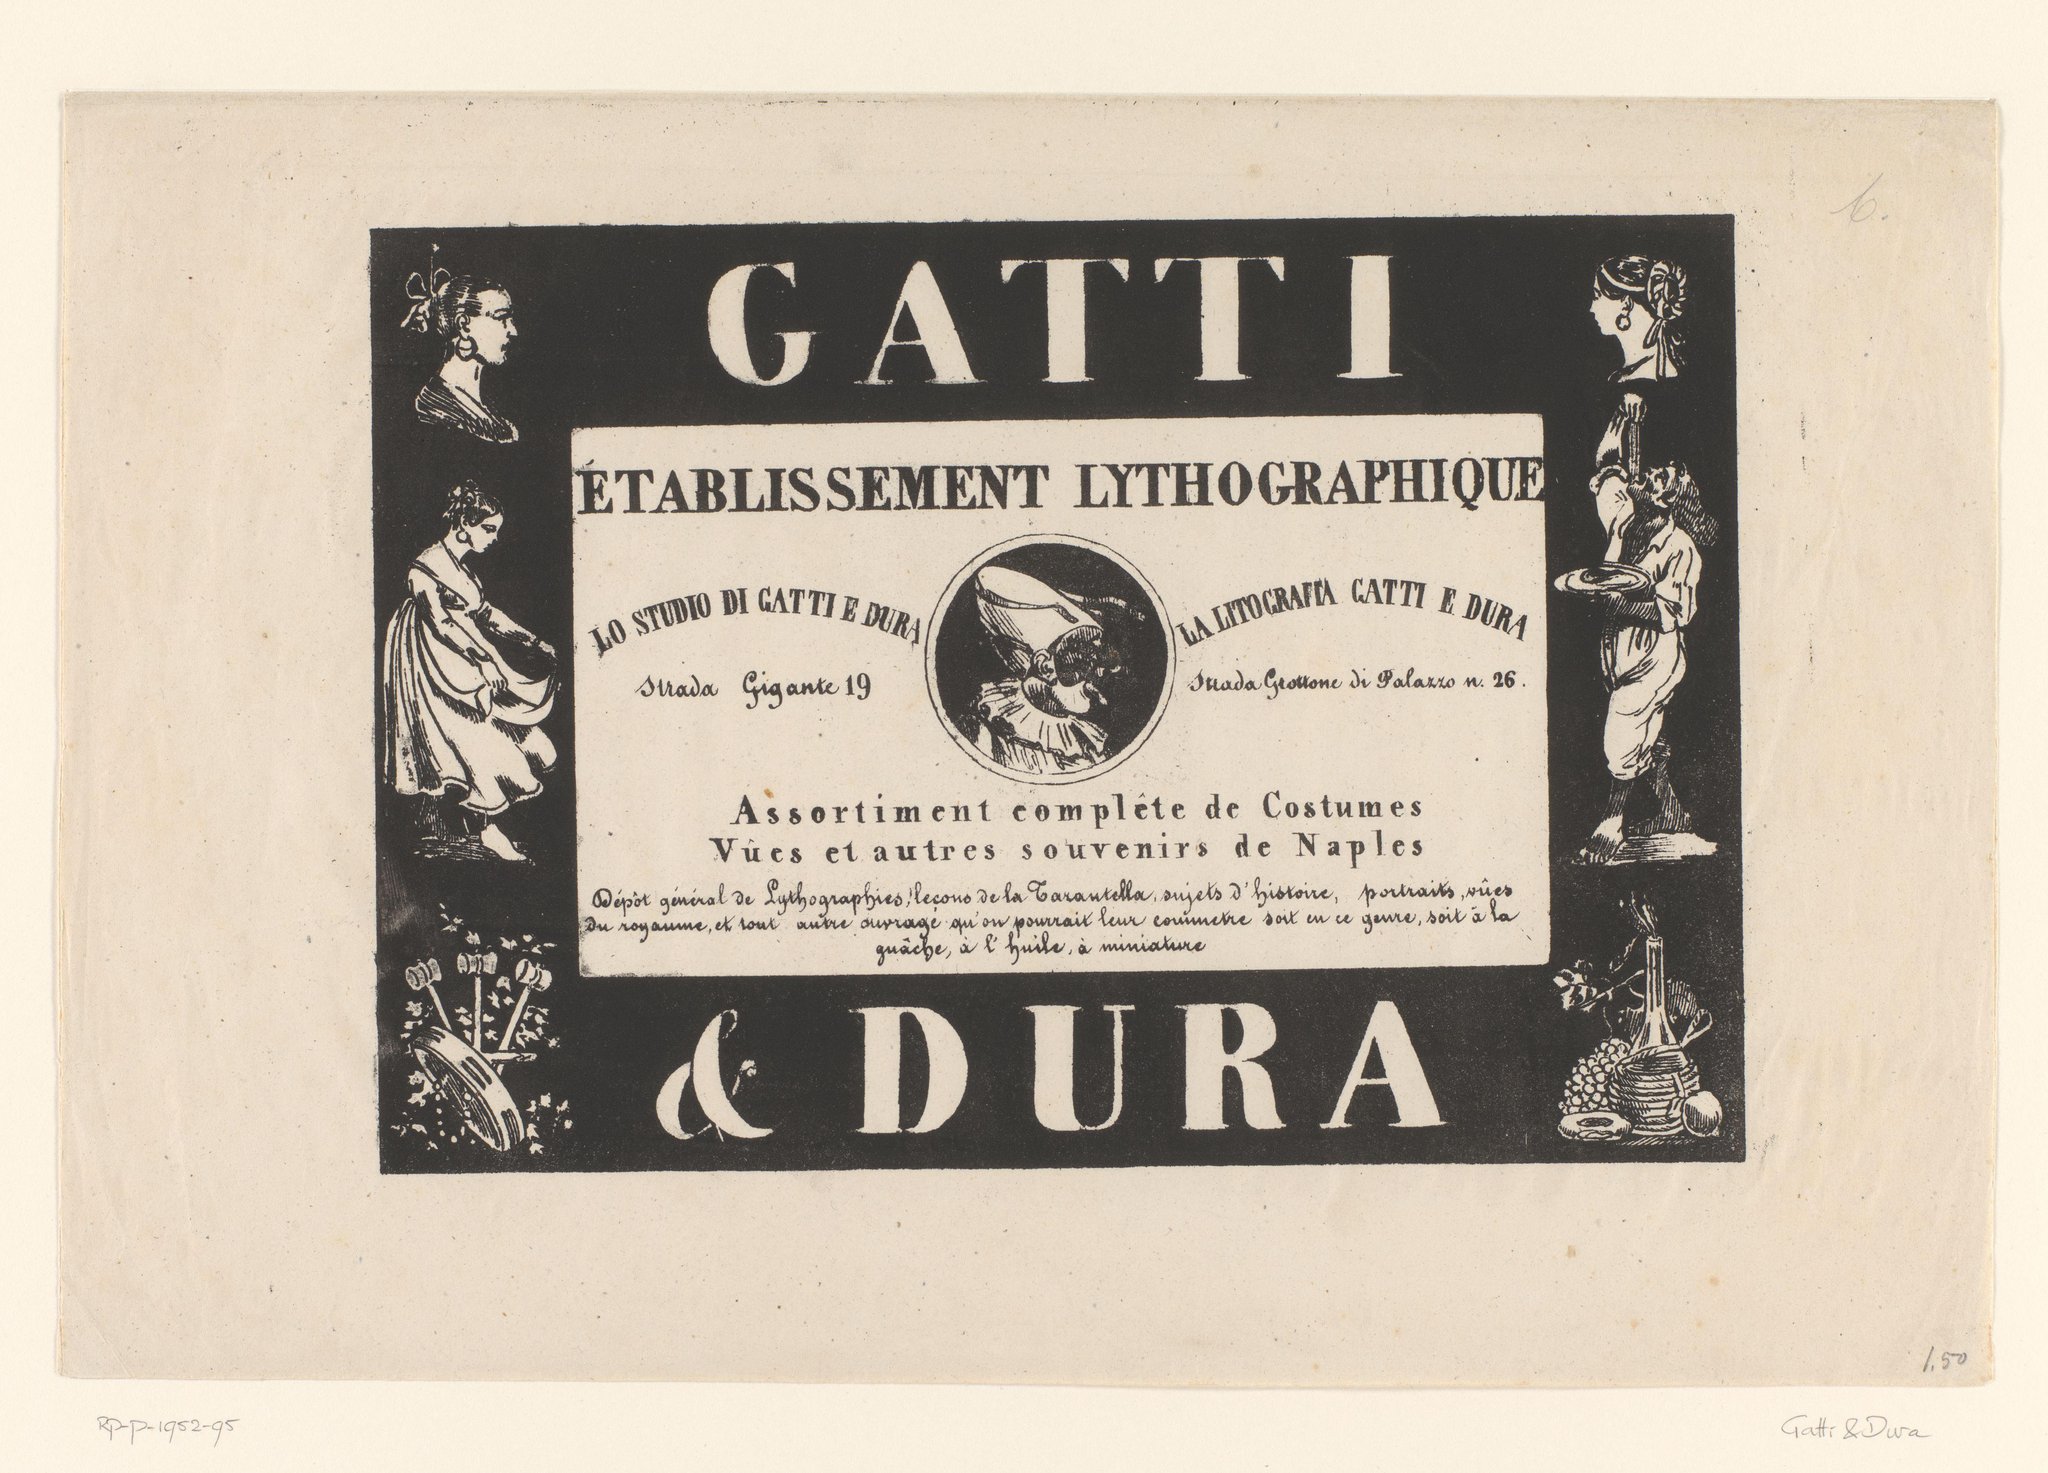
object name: advertisement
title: Gatti & Dura/ Etablissement lithografique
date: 1800-1899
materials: paper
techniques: lithograph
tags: types in 'commedia dell'arte': pierrot, folk costume, regional costume, naples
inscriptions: collector's mark: Lugt 2228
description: Advertentie van het Etablissement lithografique Gatti & Dura, met voorstellingen van figuren in traditionele kostuums uit Napels.